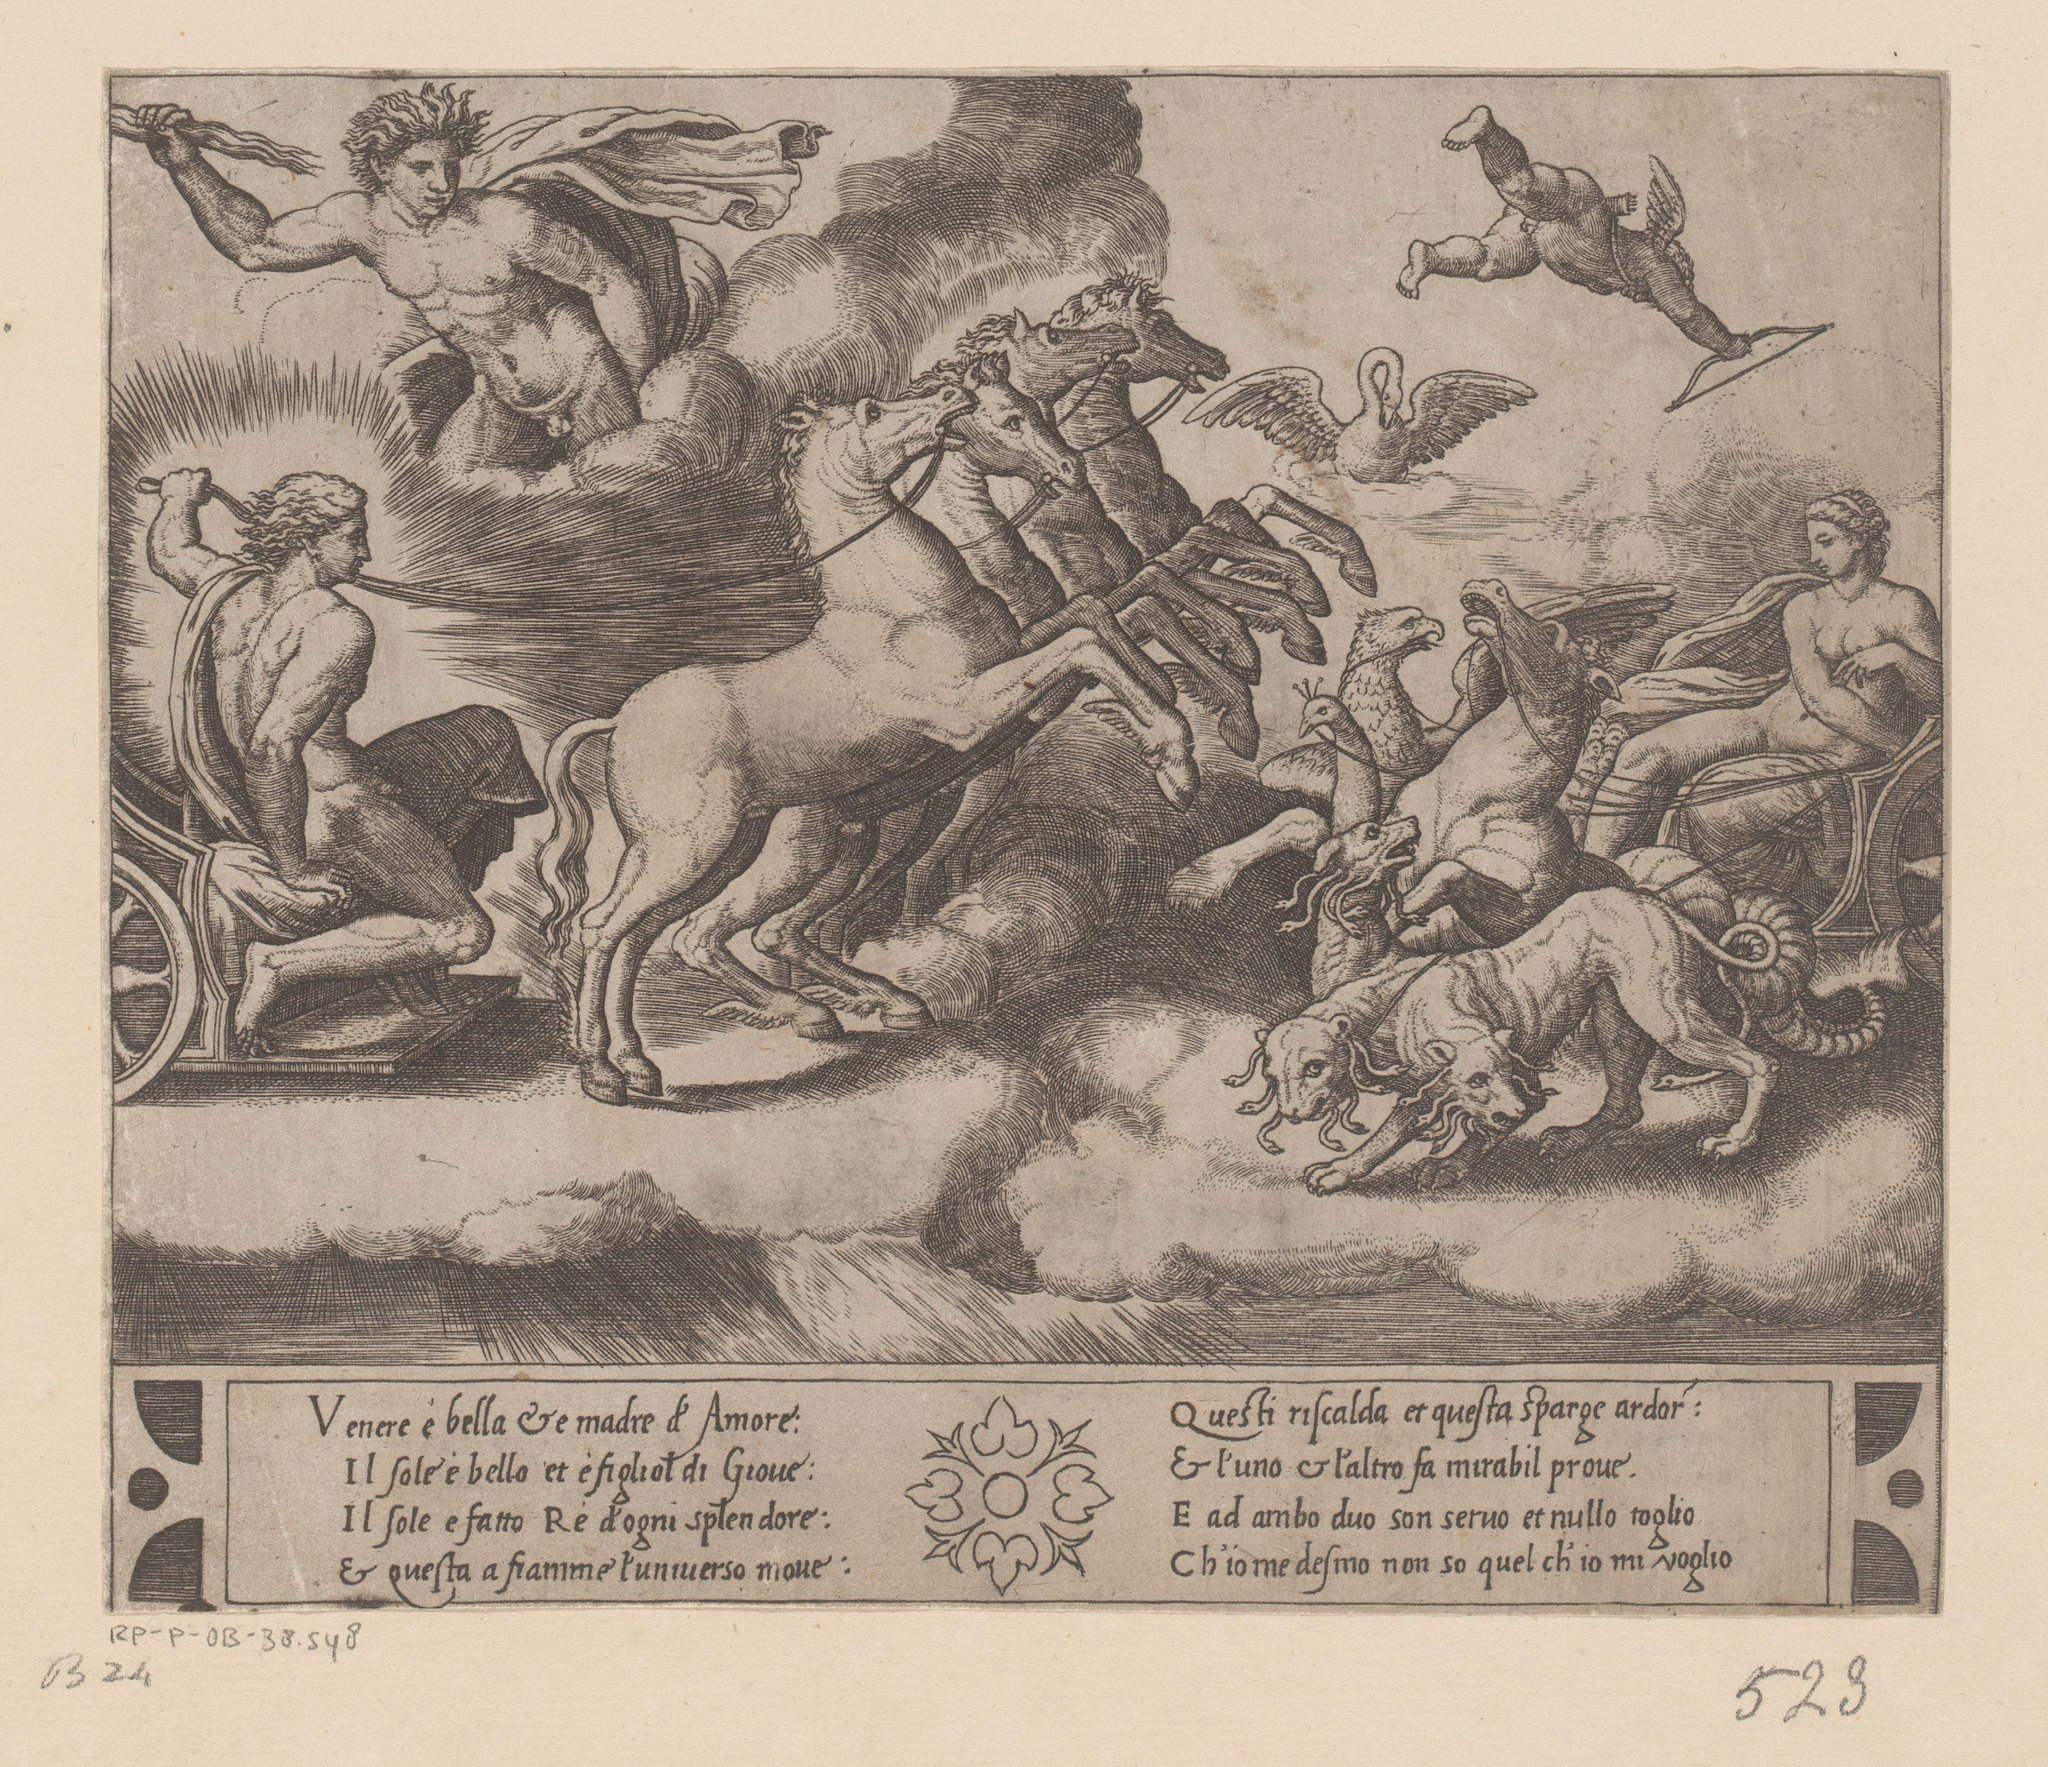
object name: print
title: Wagens van Venus en Apollo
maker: meester van de dobbelsteen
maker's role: print maker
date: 1530-1560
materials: paper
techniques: engraving, intaglio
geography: italy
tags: water-birds: swan, (story of) jupiter (zeus), (story of) cupid, amor (eros), apollo in the chariot of the sun, drawn by four horses, usually preceded by aurora holding a torch; 'carro del sole' (ripa), (story of) venus (aphrodite), roman chariot, quadriga ~ triumph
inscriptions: collector's mark: Lugt 240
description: Links Apollo op zijn wagen met vier naast elkaar aangespannen paarden. Rechts wordt de wagen van Venus getrokken door een adelaar, een pauw, een zeepaard en de driekoppige hond Cerberus met slangenstaart. Linksboven Jupiter met bliksemschicht en rechtsboven een zwaan en Amor met zijn boog. Italiaanse tekst in twee kolommen in ondermarge.